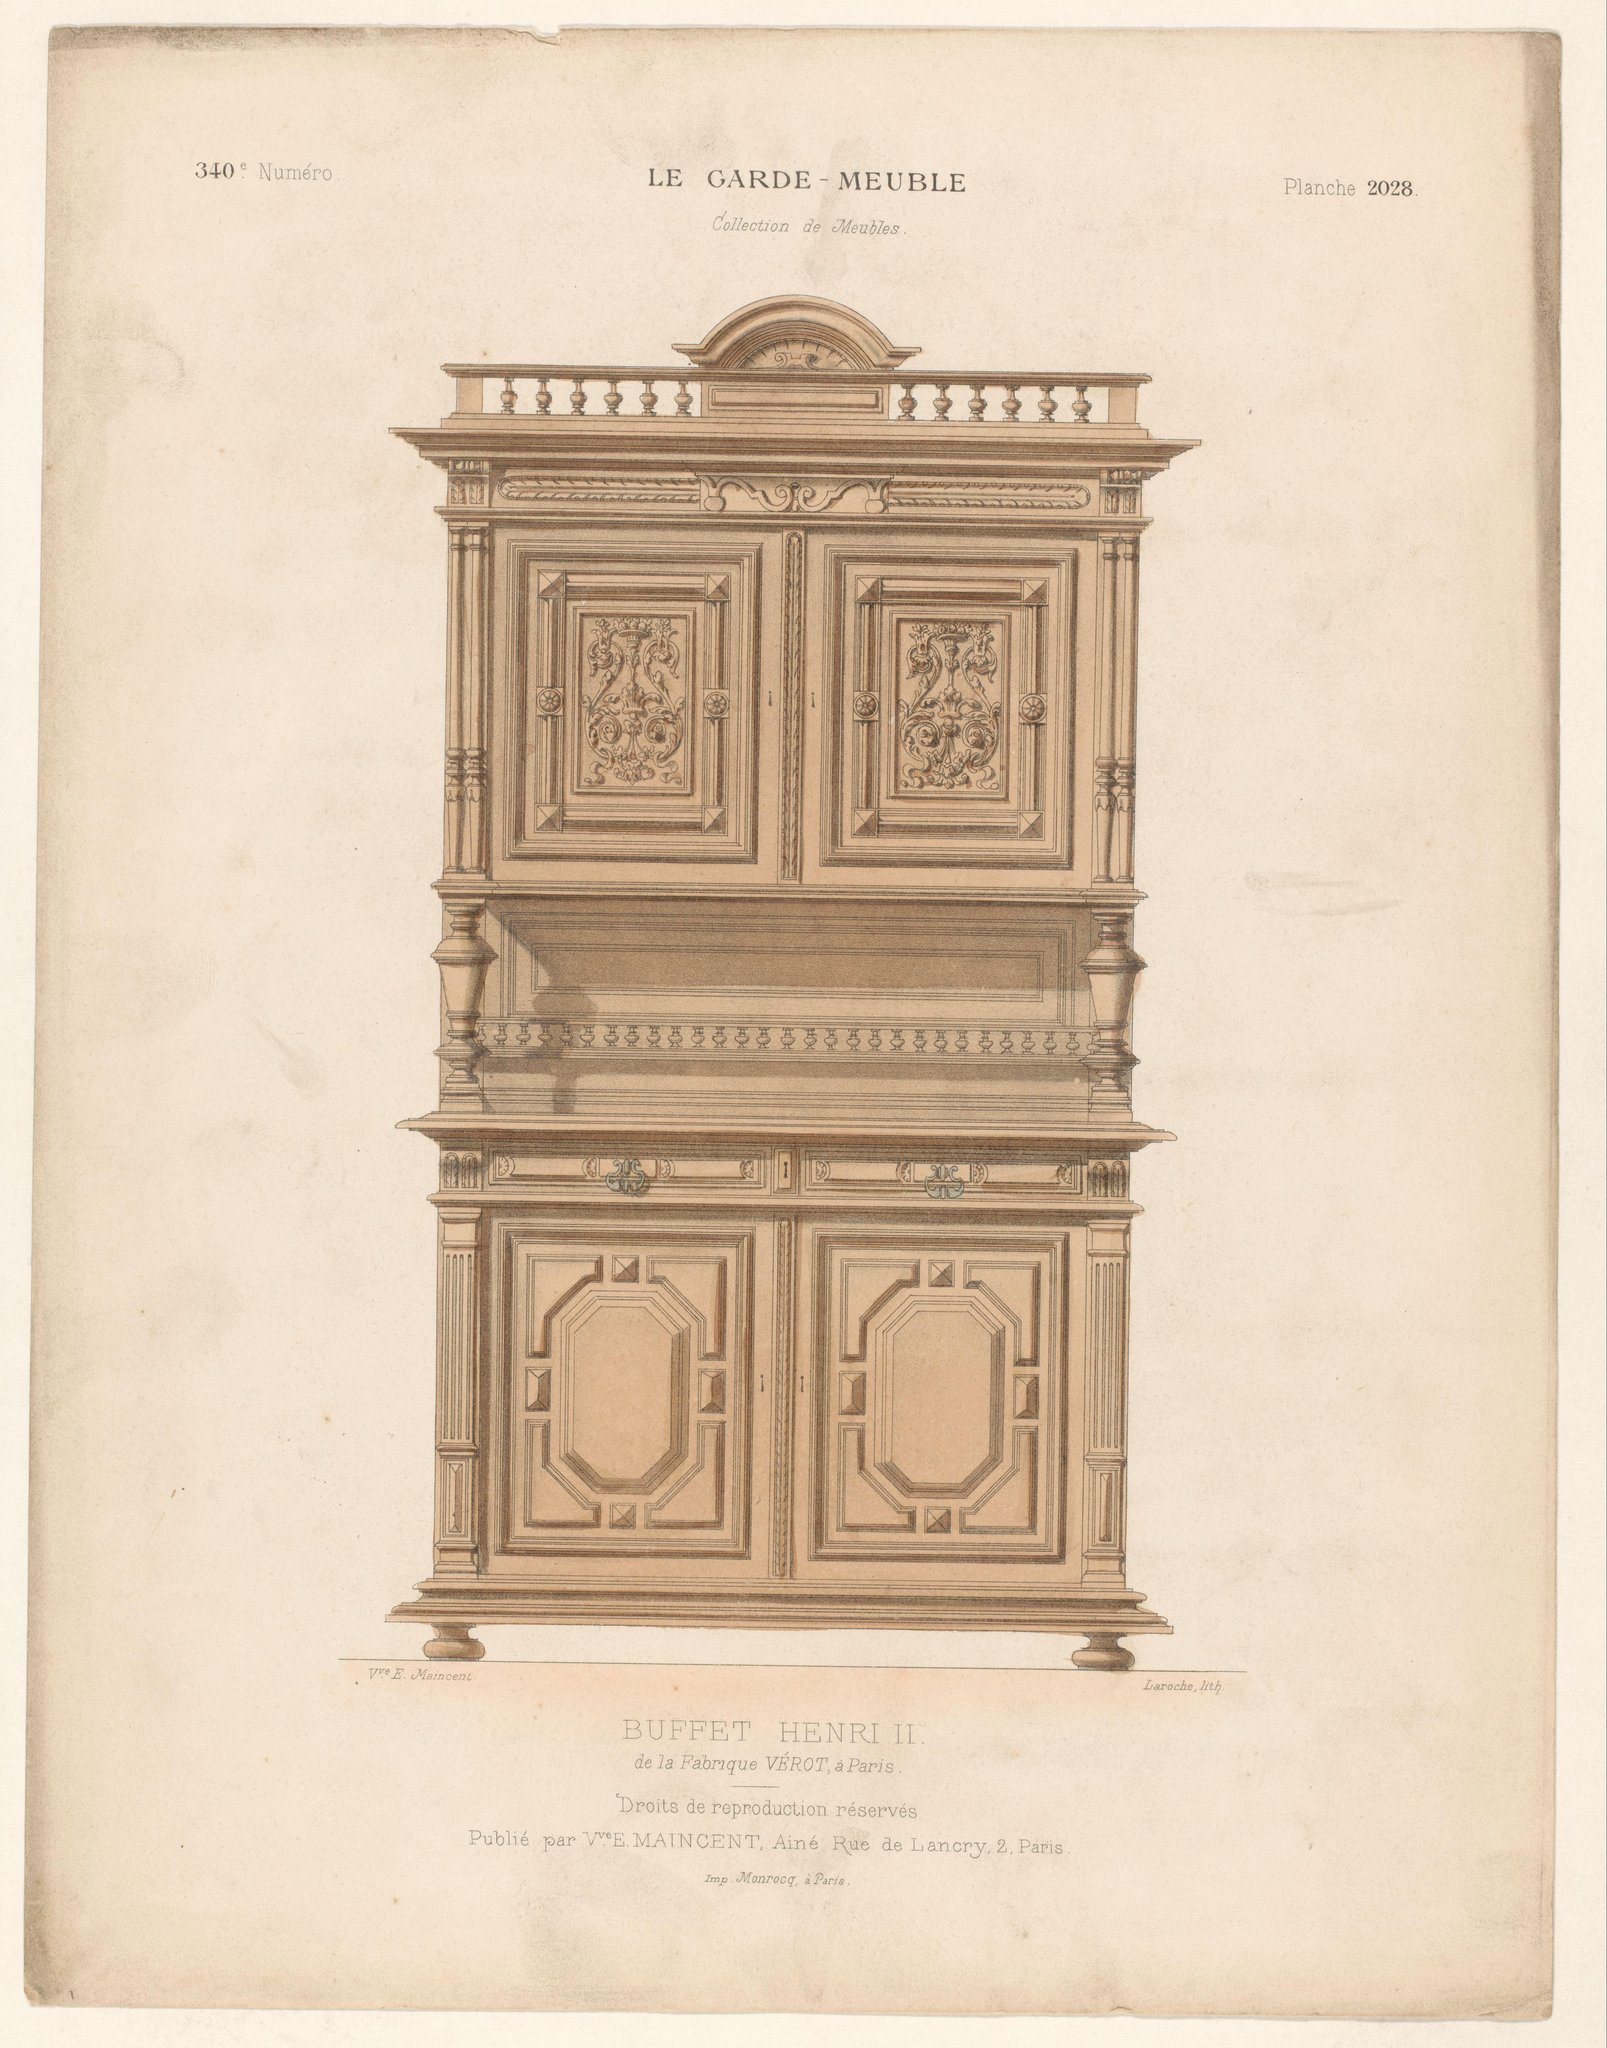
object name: print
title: Buffet Henri II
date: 1895-1935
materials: paper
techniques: hand coloring, lithograph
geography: paris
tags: furniture for storage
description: Ieder Livraison in de serie Le Garde-Meuble bevat negen platen: drie 'sièges' (zitmeubels), drie 'meubles' (diverse meubels zoals tafels en kasten) en drie 'tentures' (gordijnen en draperieën).